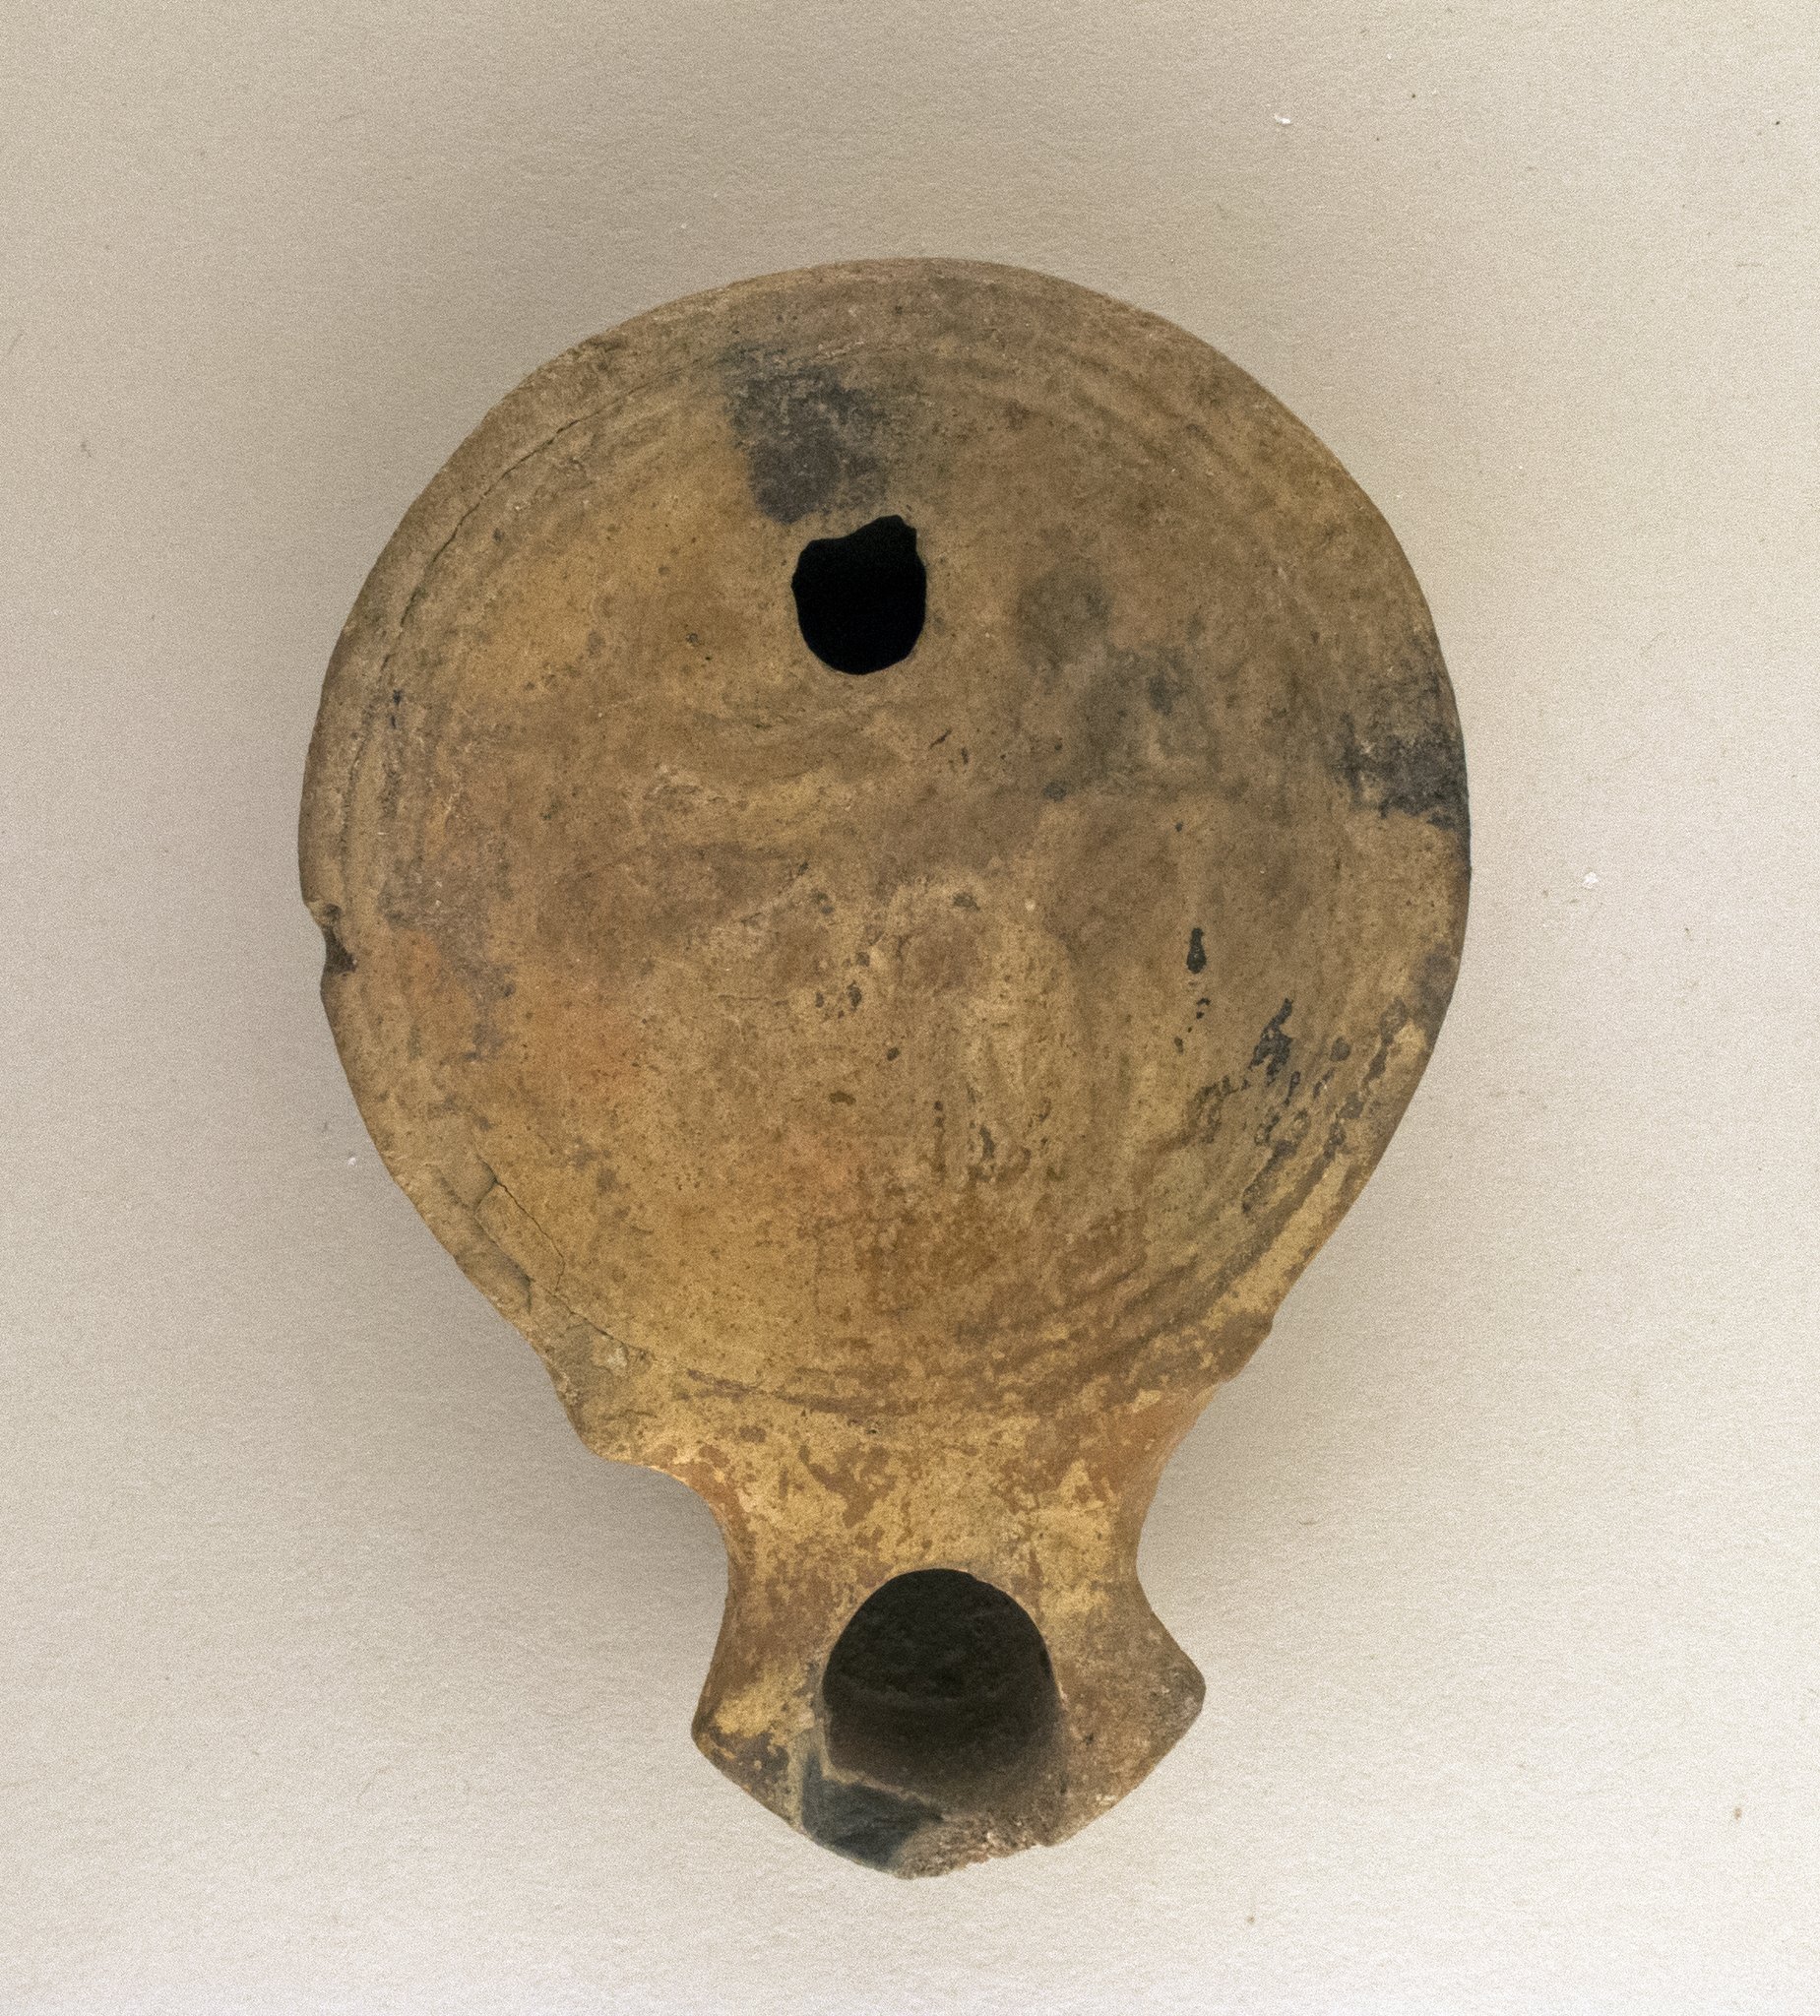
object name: lamp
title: Terracotta oil lamp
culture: roman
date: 1-50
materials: terracotta